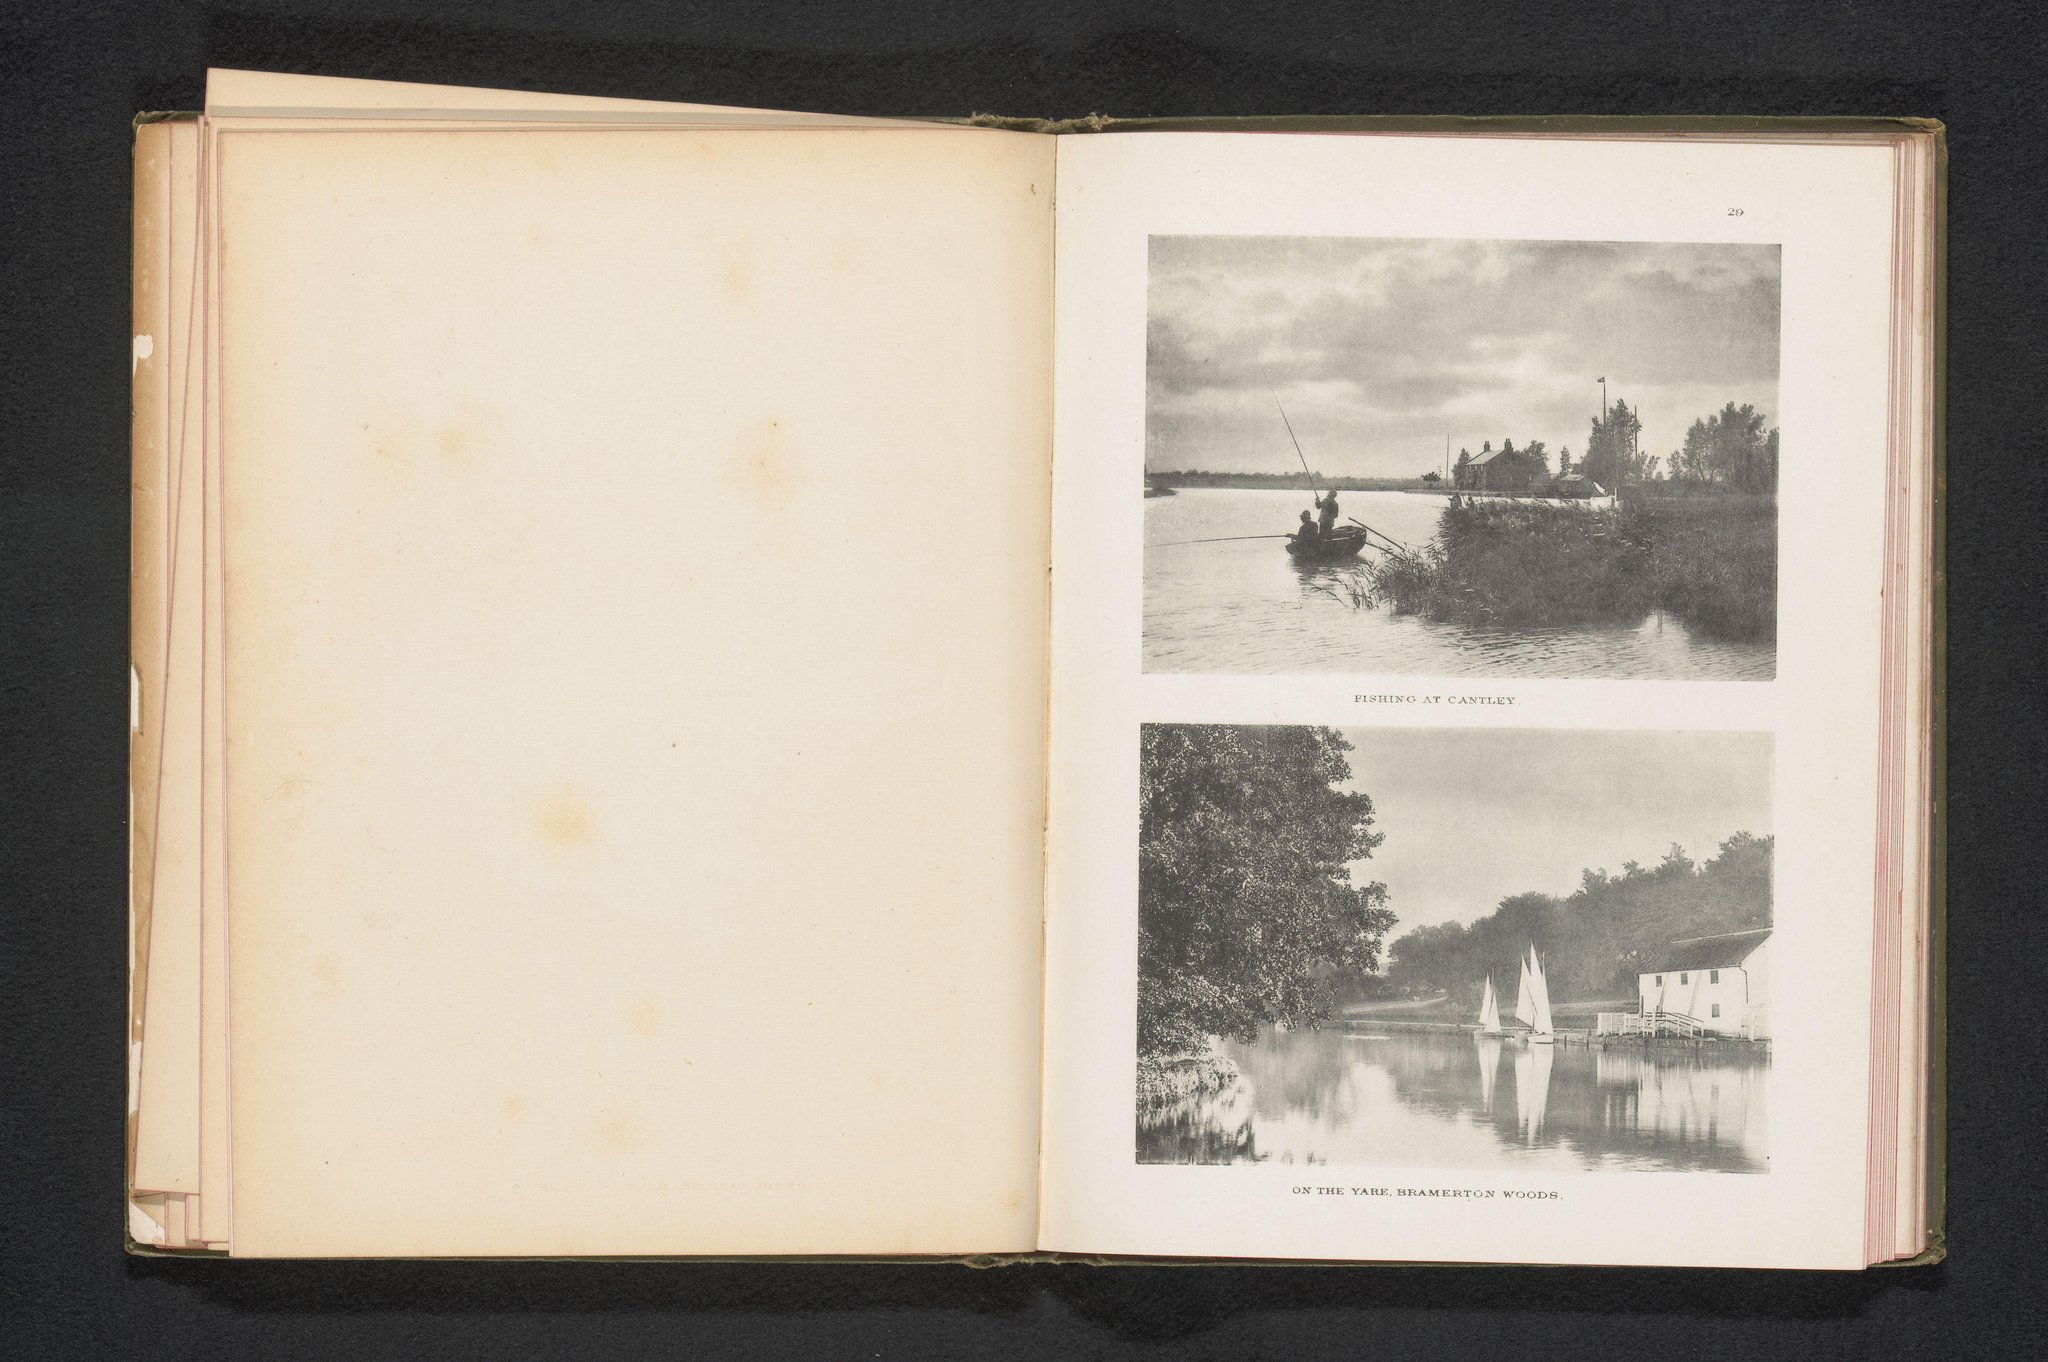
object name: page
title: Gezicht op de Yare met zeilboten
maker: john payne jennings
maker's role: fotograaf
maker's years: 1843-1926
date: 1886-1891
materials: paper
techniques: photograph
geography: surrey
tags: sailing-ship, sailing-boat, river, landscapes with waters, waterscapes, seascapes (in the temperate zone)